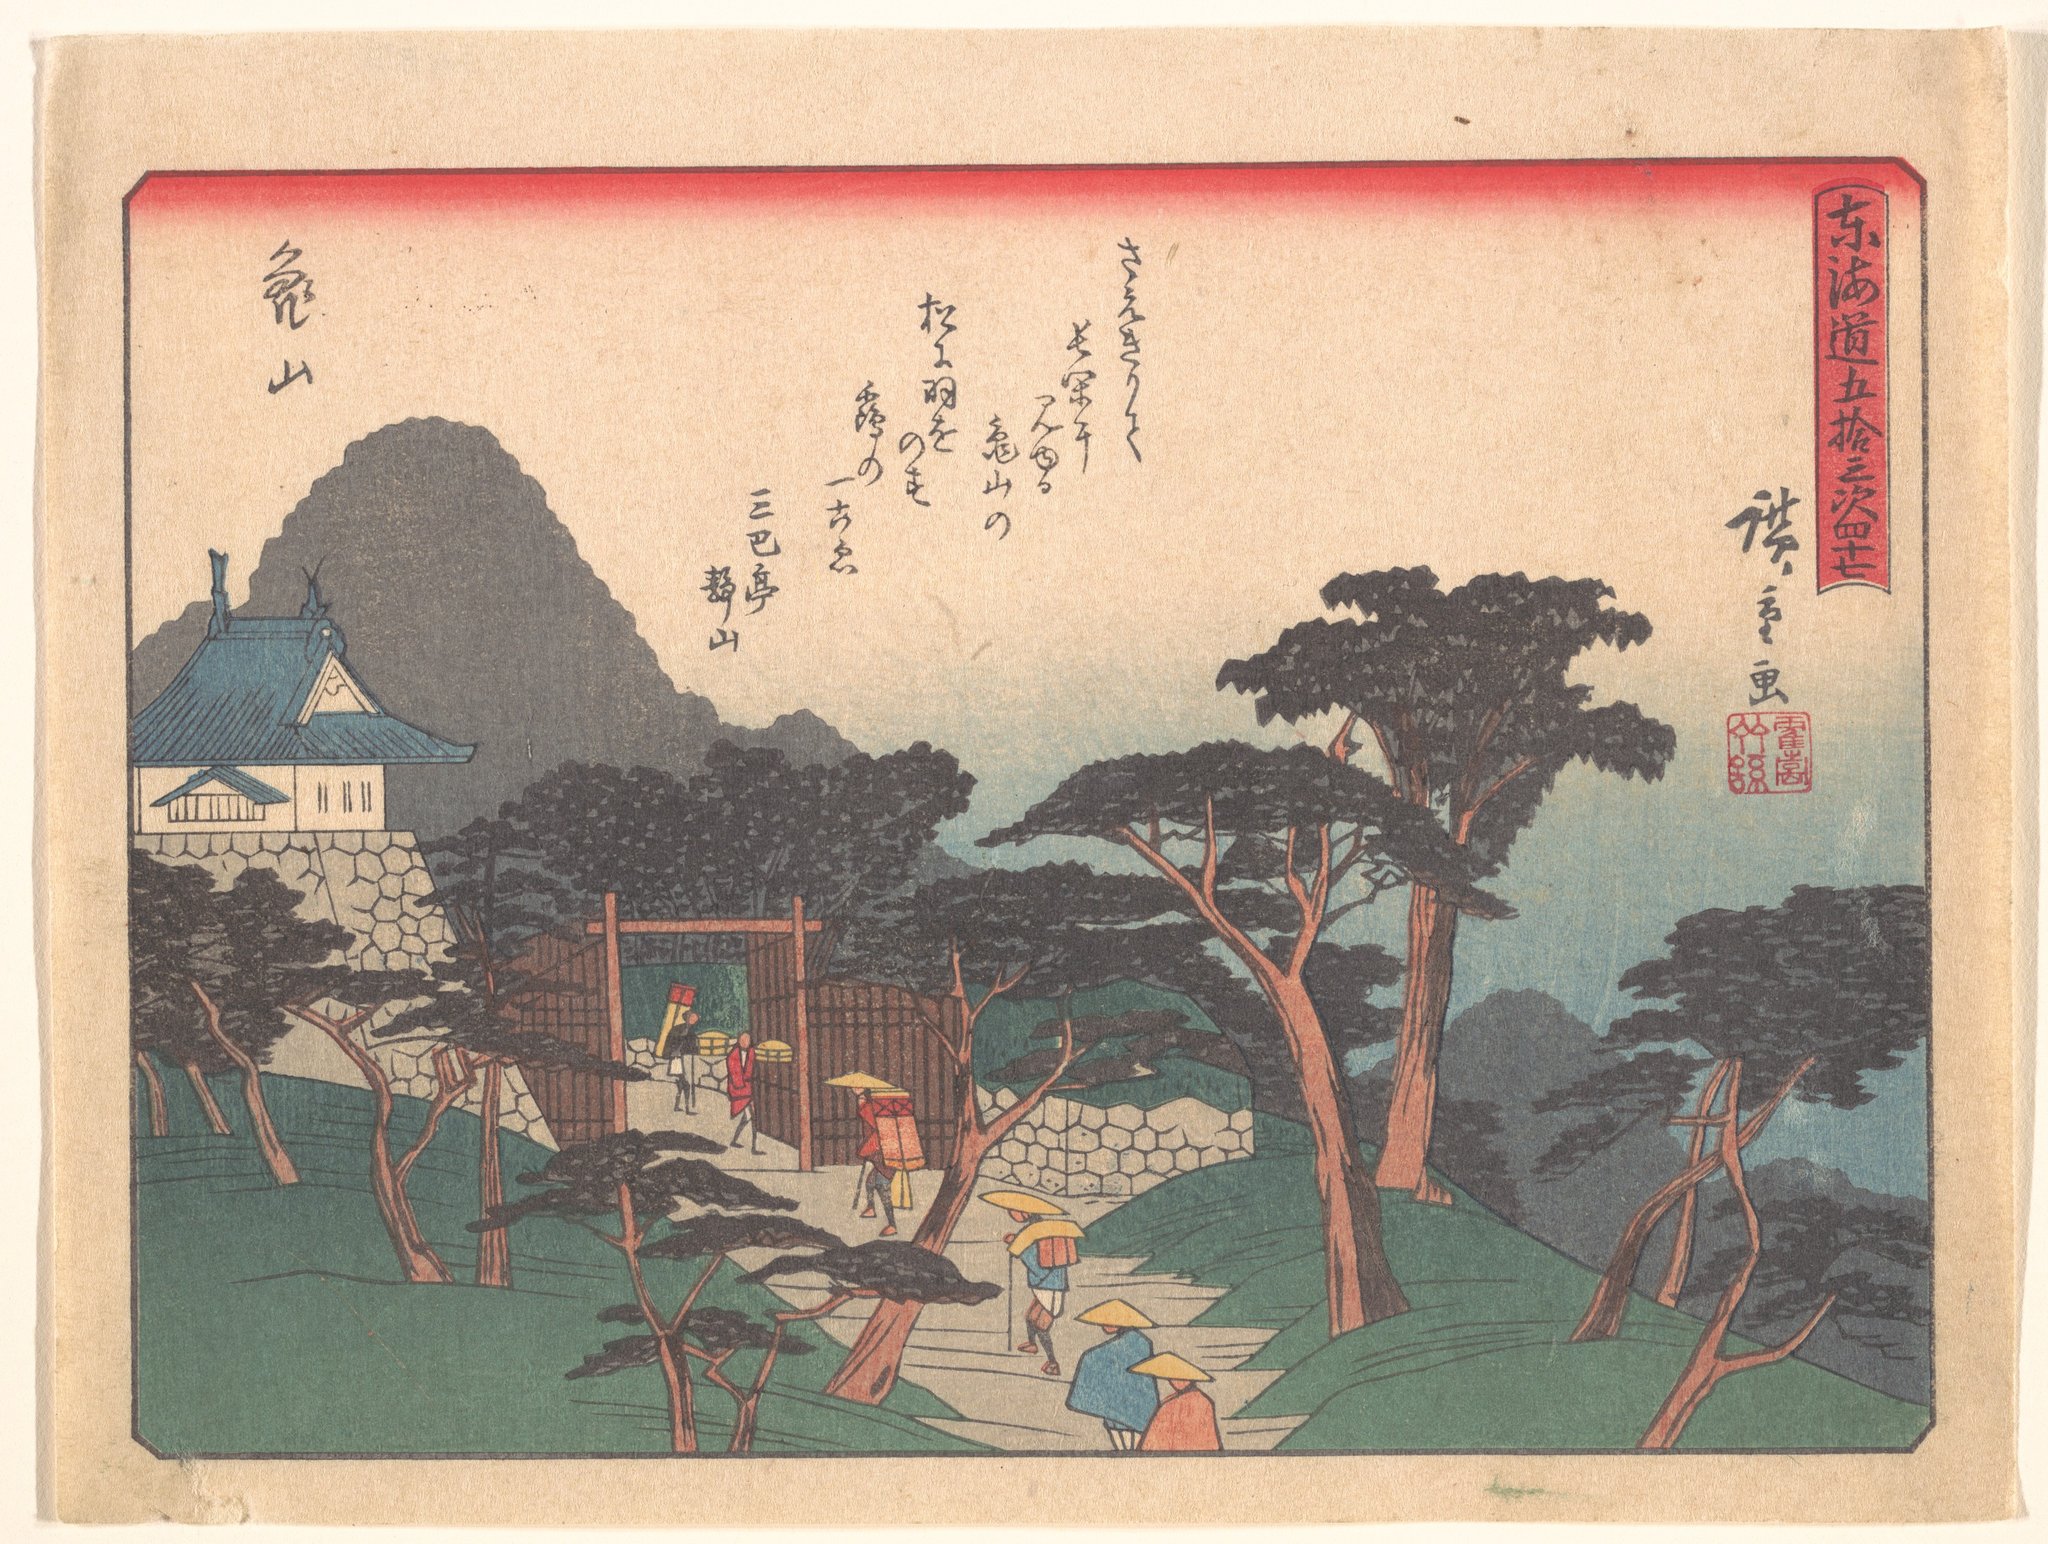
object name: print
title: Kameyama, from the series The Fifty-three Stations of the Tōkaidō Road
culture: japanese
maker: utagawa hiroshige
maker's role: artist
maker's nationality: japanese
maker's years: 1797-1858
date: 1901-1933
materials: ink, paper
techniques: woodblock print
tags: human figures,buildings,trees